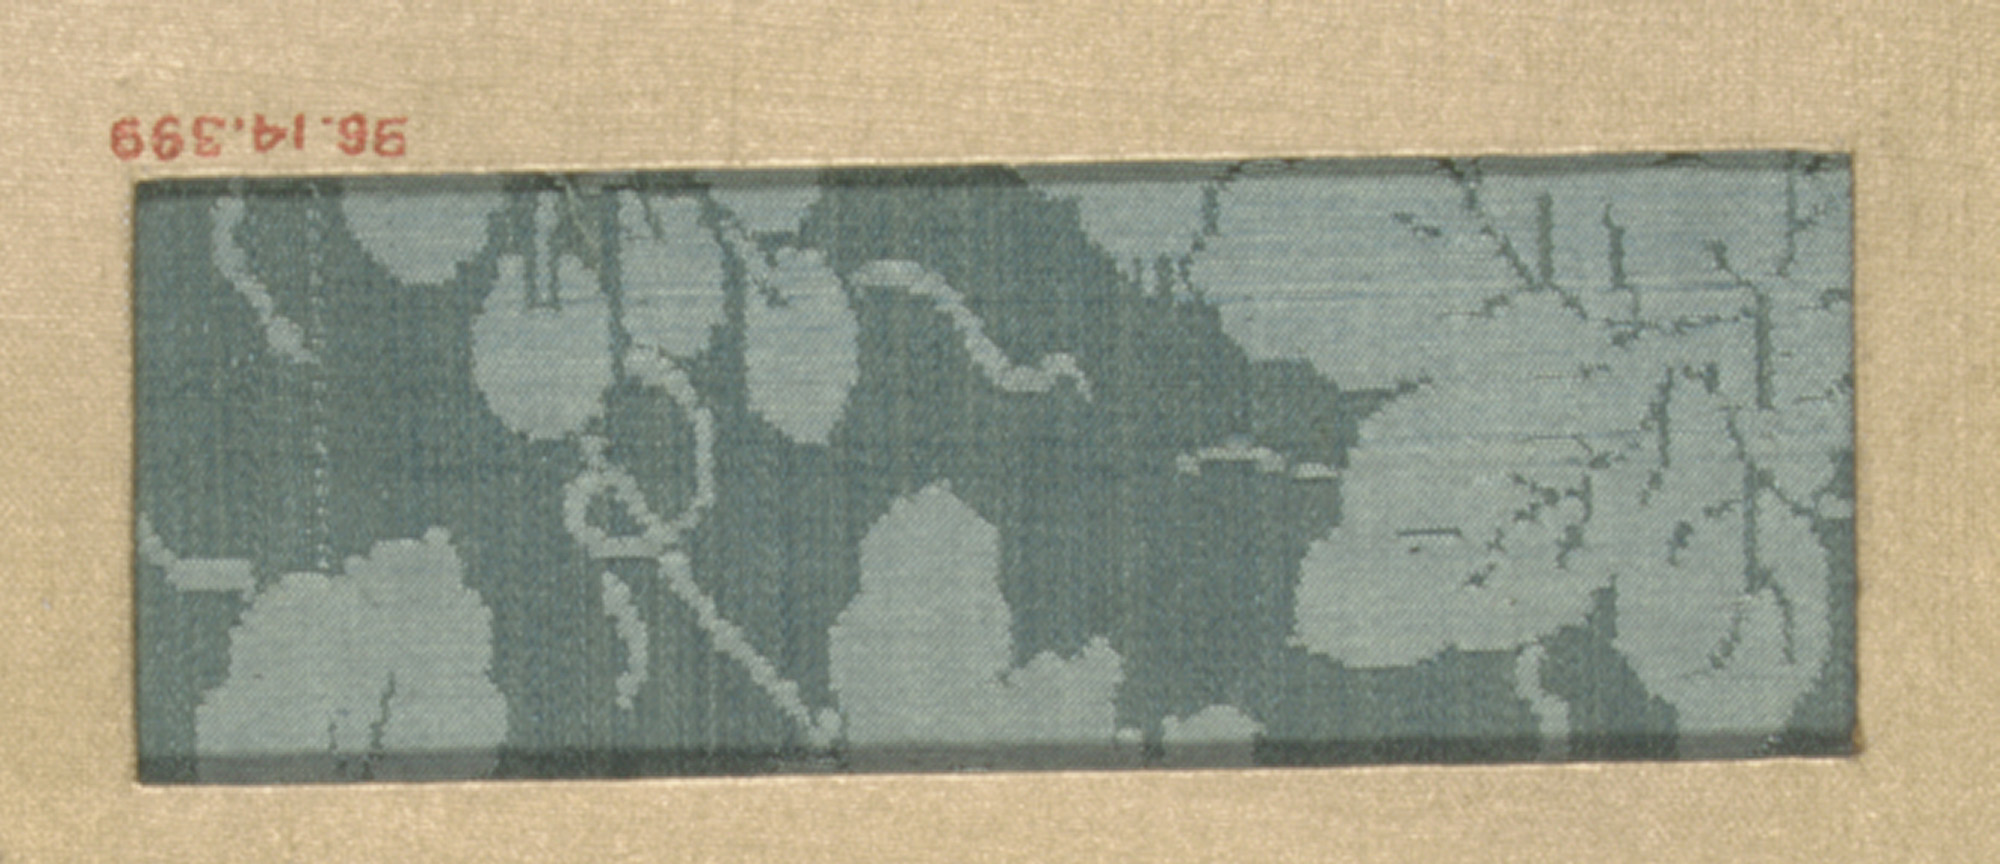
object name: piece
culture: chinese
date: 1701-1900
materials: silk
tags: flowers